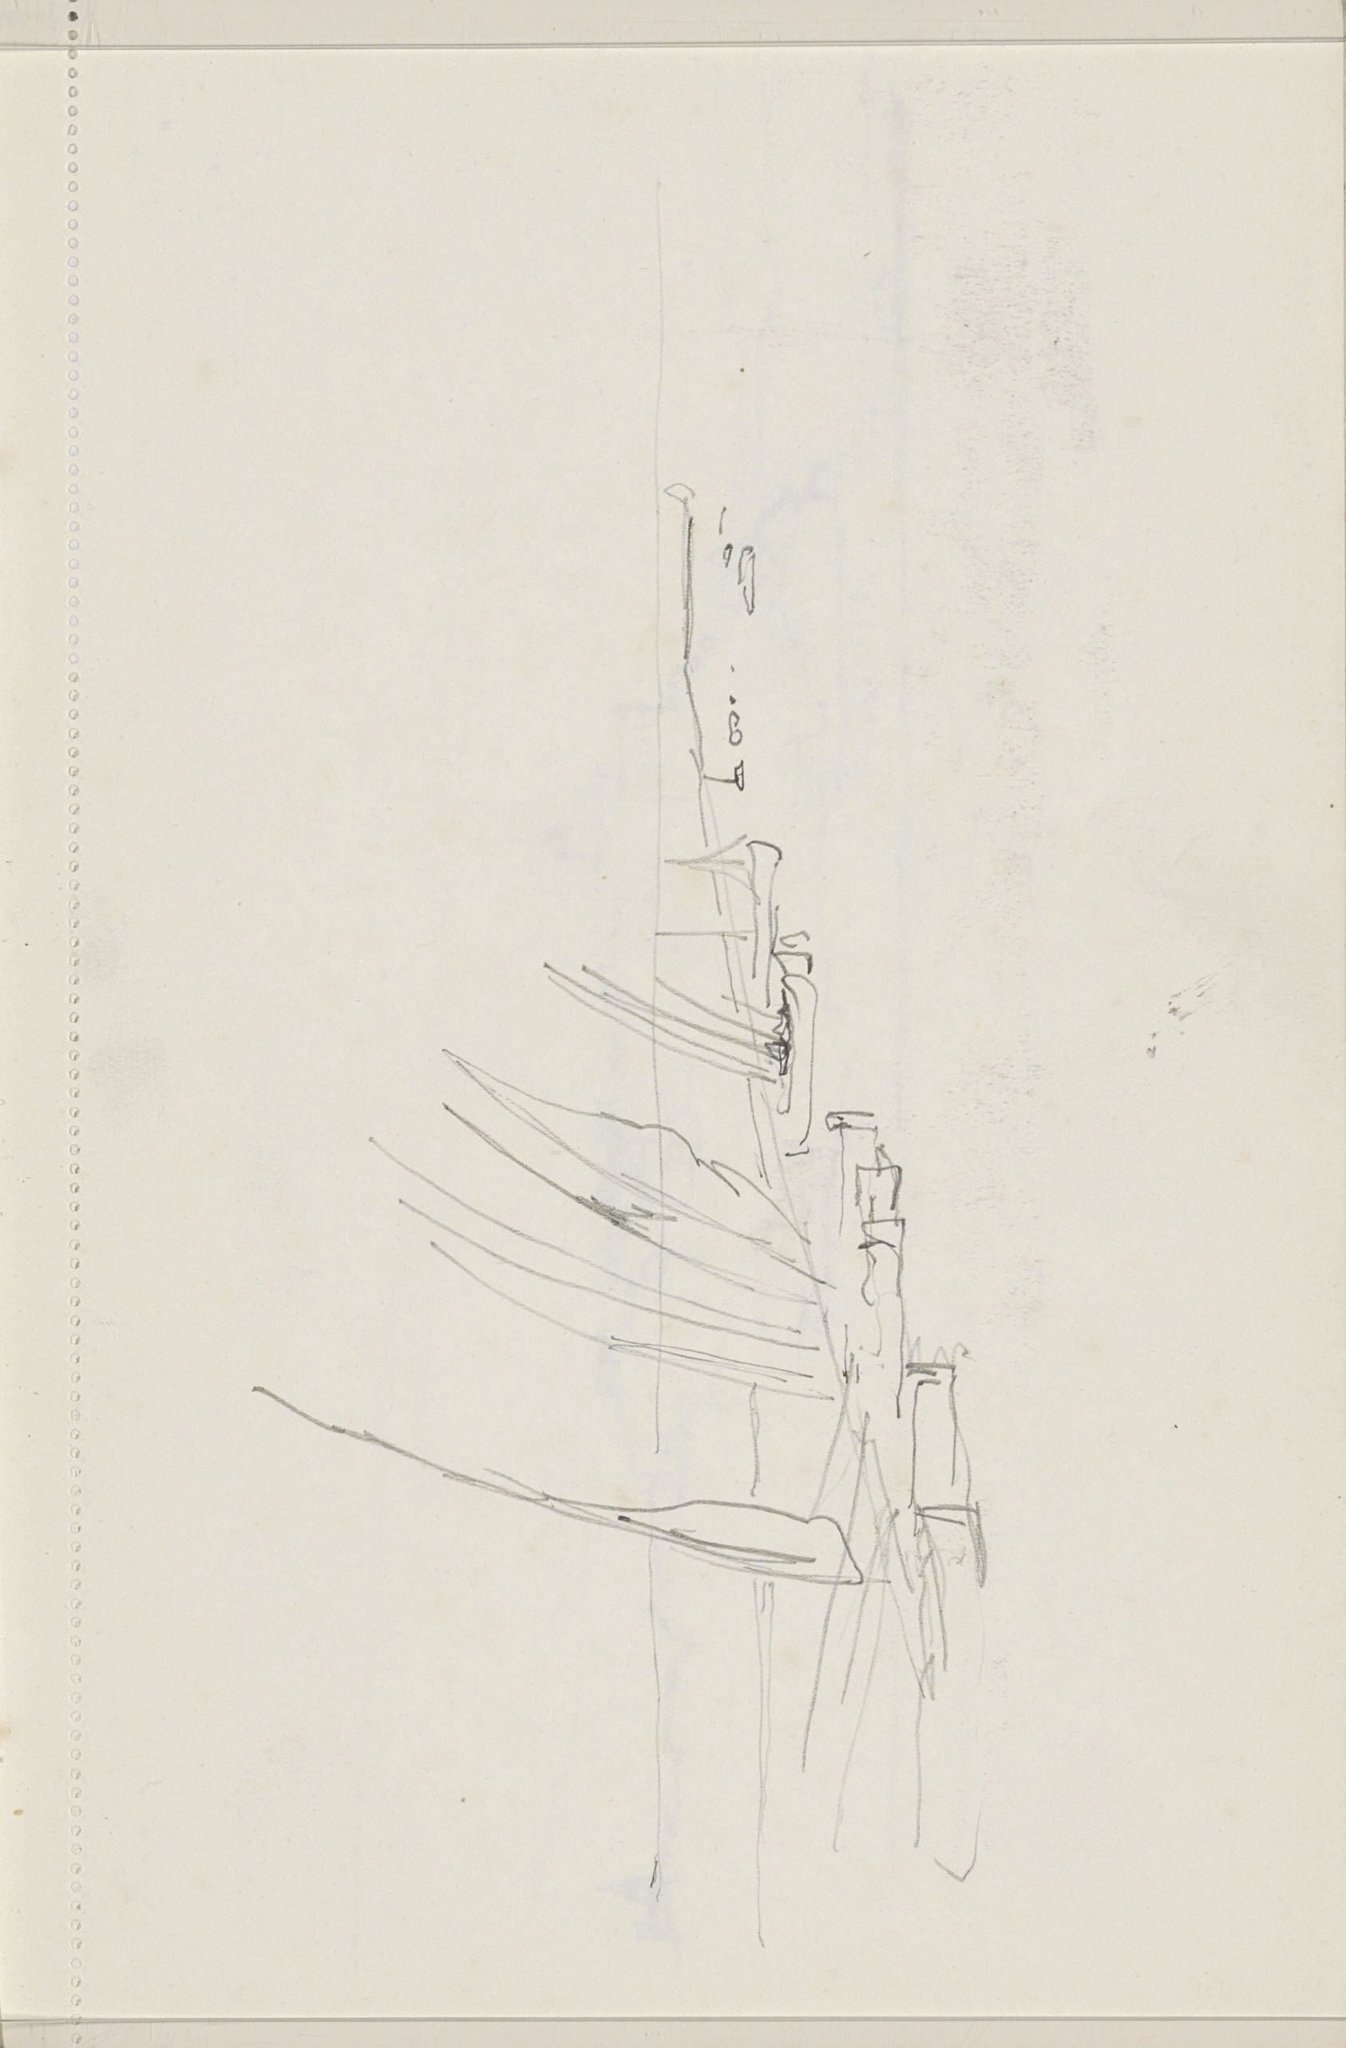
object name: sketchbook leaf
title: Zeilboten in een binnenhaven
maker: cornelis vreedenburgh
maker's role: draughtsman, print maker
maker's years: 1880-1946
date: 1936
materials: paper, pencil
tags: sailing-ship, sailing-boat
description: Blad 34 recto uit een schetsboek met 73 bladen.